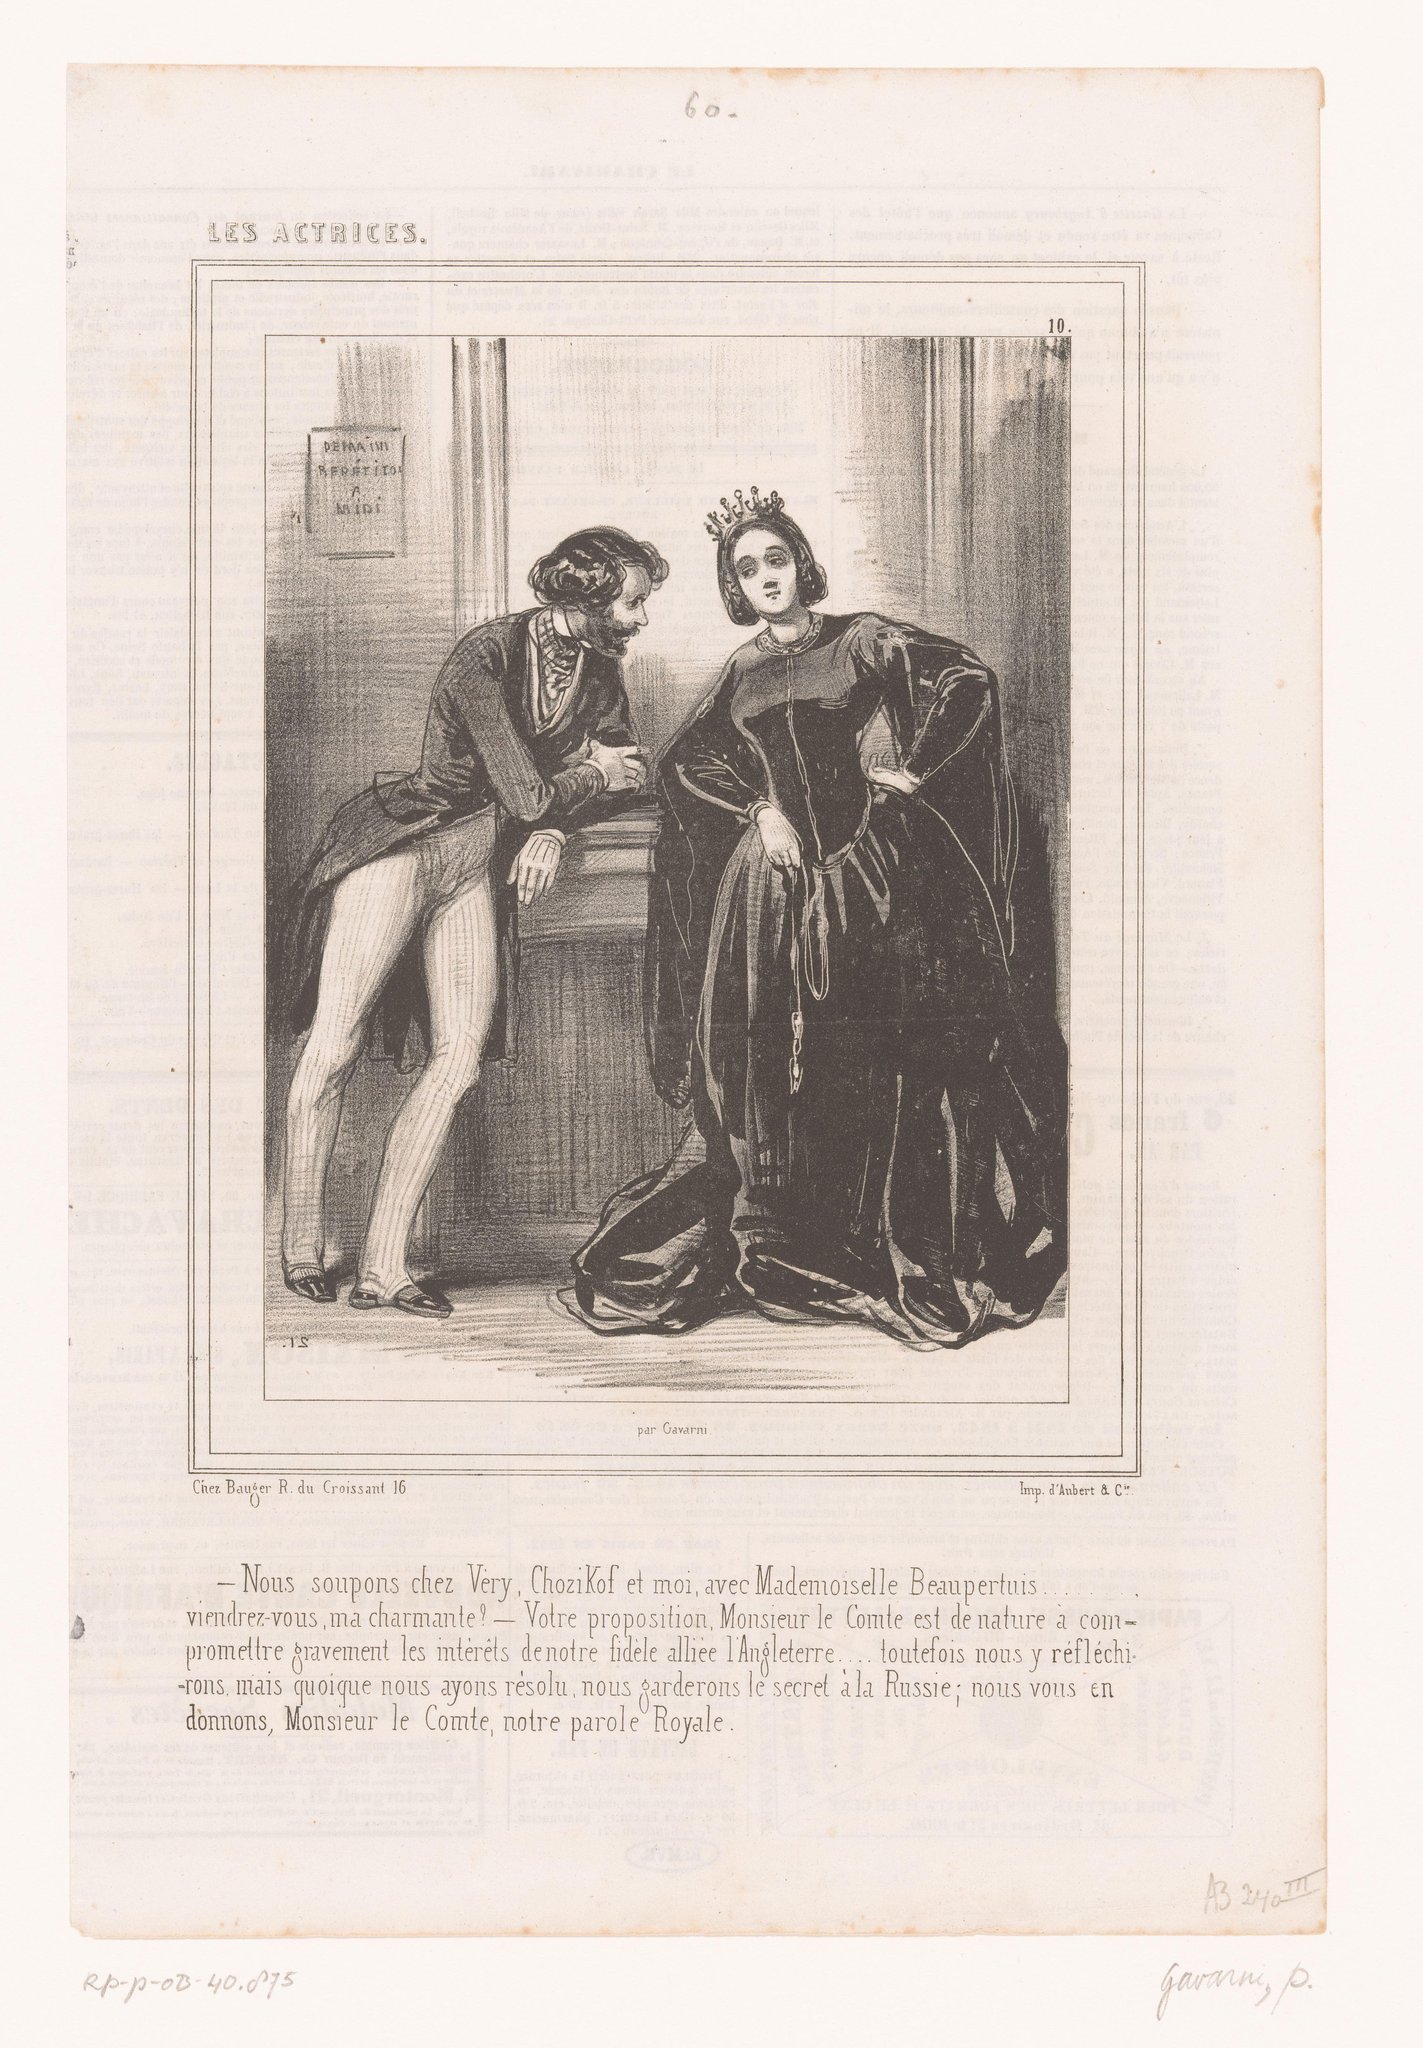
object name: print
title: Acteur nodigt actrice uit om te komen eten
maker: paul gavarni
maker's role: draughtsman, print maker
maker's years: 1804-1866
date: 1843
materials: paper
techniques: lithograph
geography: paris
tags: actor, actress (non-work situations)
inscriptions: collector's mark: Lugt 2228a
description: Prent gebruikt voor: La Caricature, 12 juli 1840, en voor: Le Charivari, 6 april 1843.